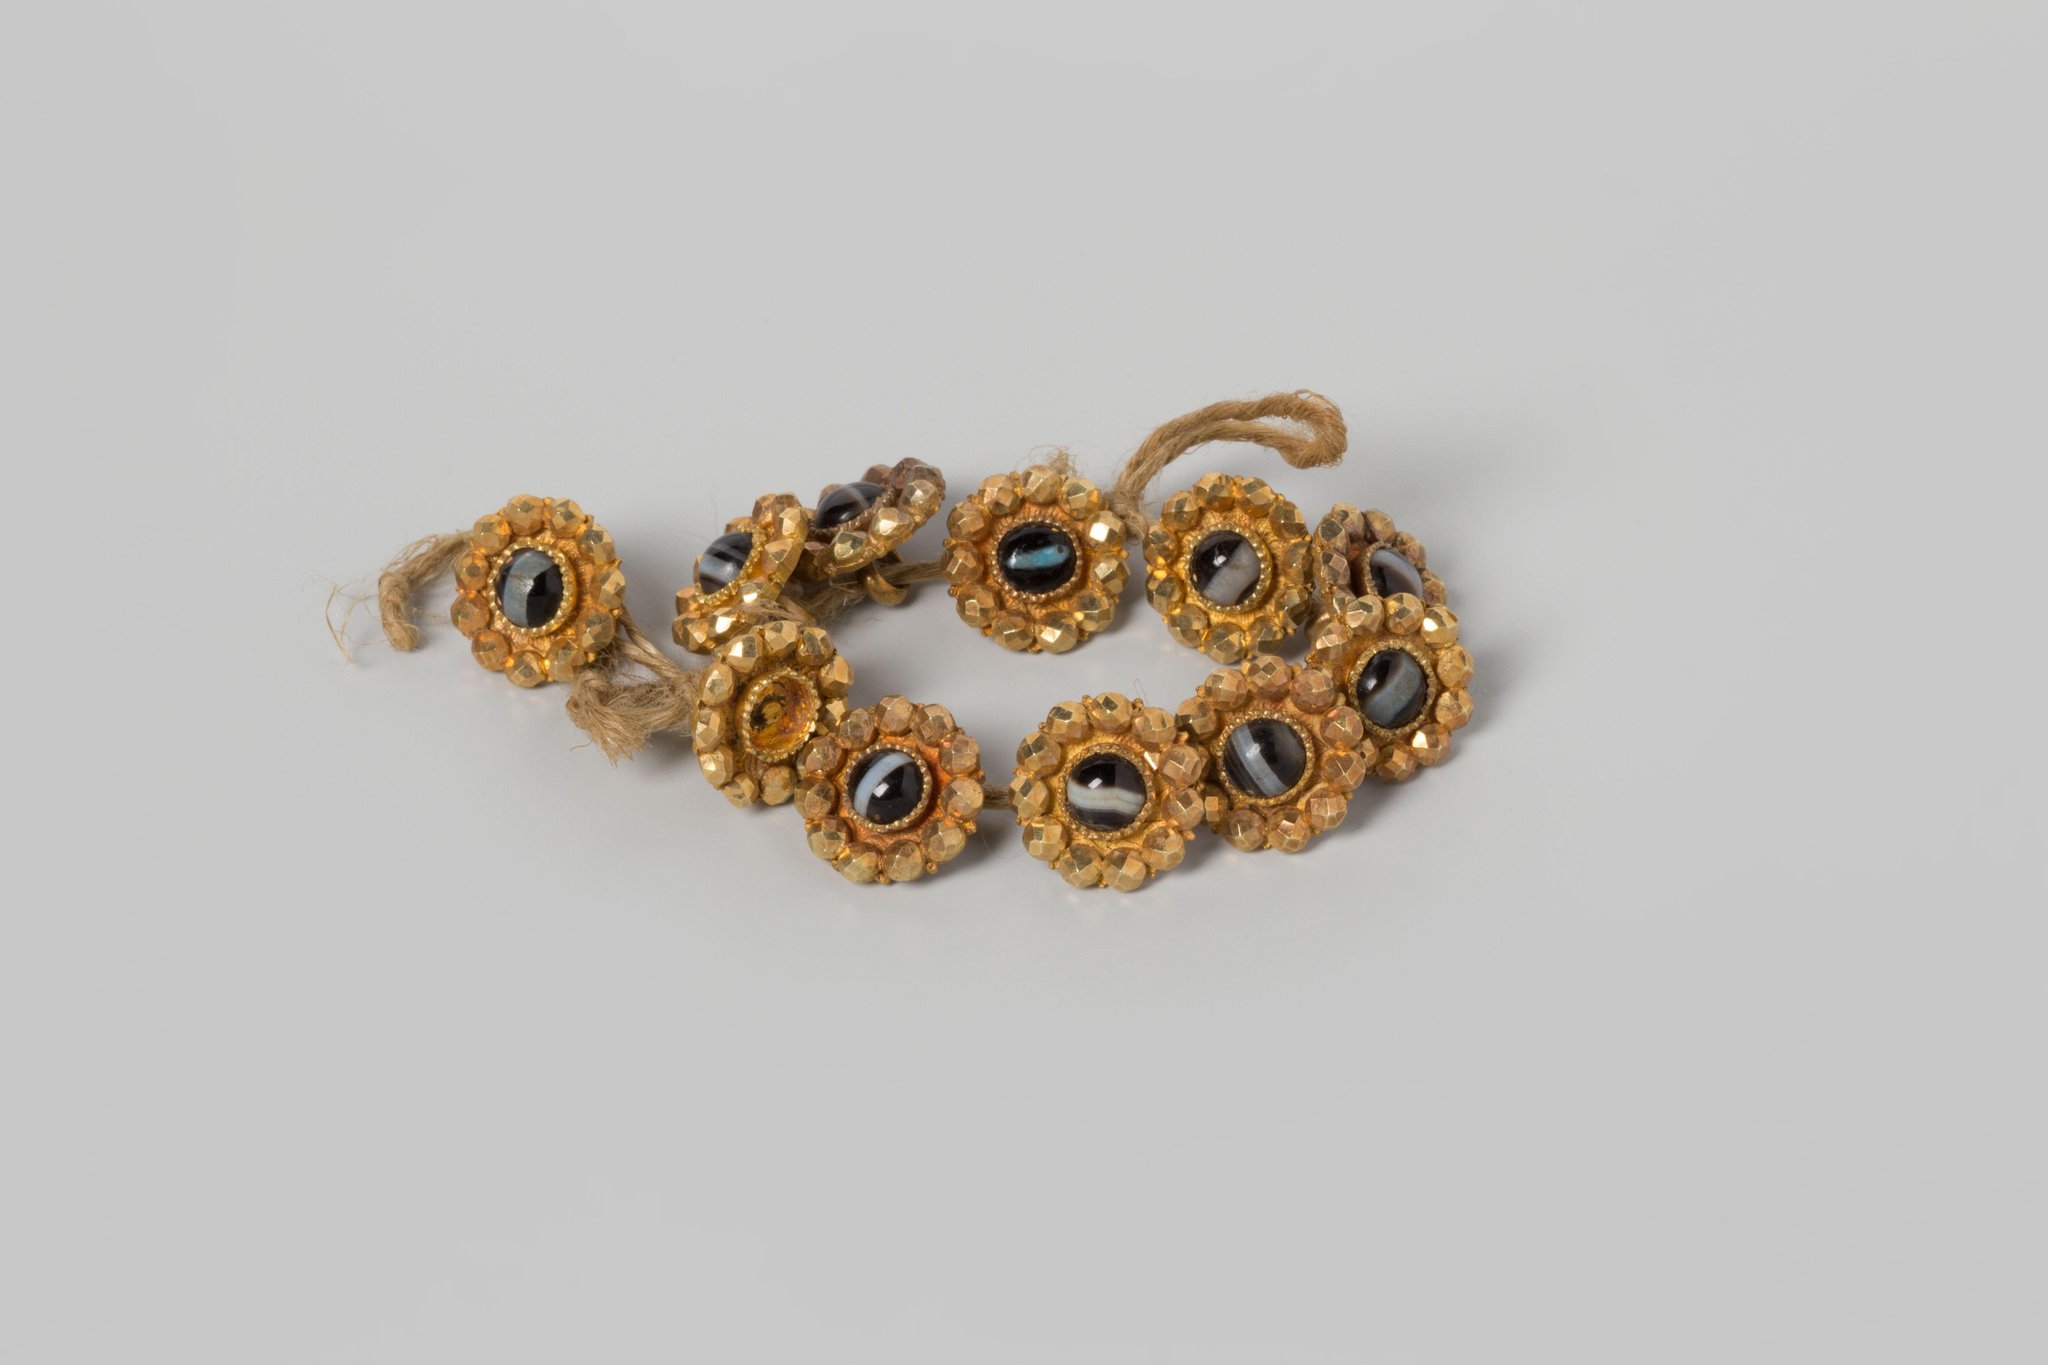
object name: button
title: Knopen, elf stuks aan een touw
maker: Anonymous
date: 1880-1940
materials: glass, metal, fiber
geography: europe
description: Knopen, elf stuks aan een touw. De knopen zijn rond, goudkleurig en hebben een oog aan de achterzijde. De stenen hebben de vorm van een rozet en in het midden is een rondgeslepen stuk steen of glas gezet in een goudkleurige parelrand. Daaromheen een grovere gefacetteerde parelrand. Uit één van de stenen is de zetting verdwenen.